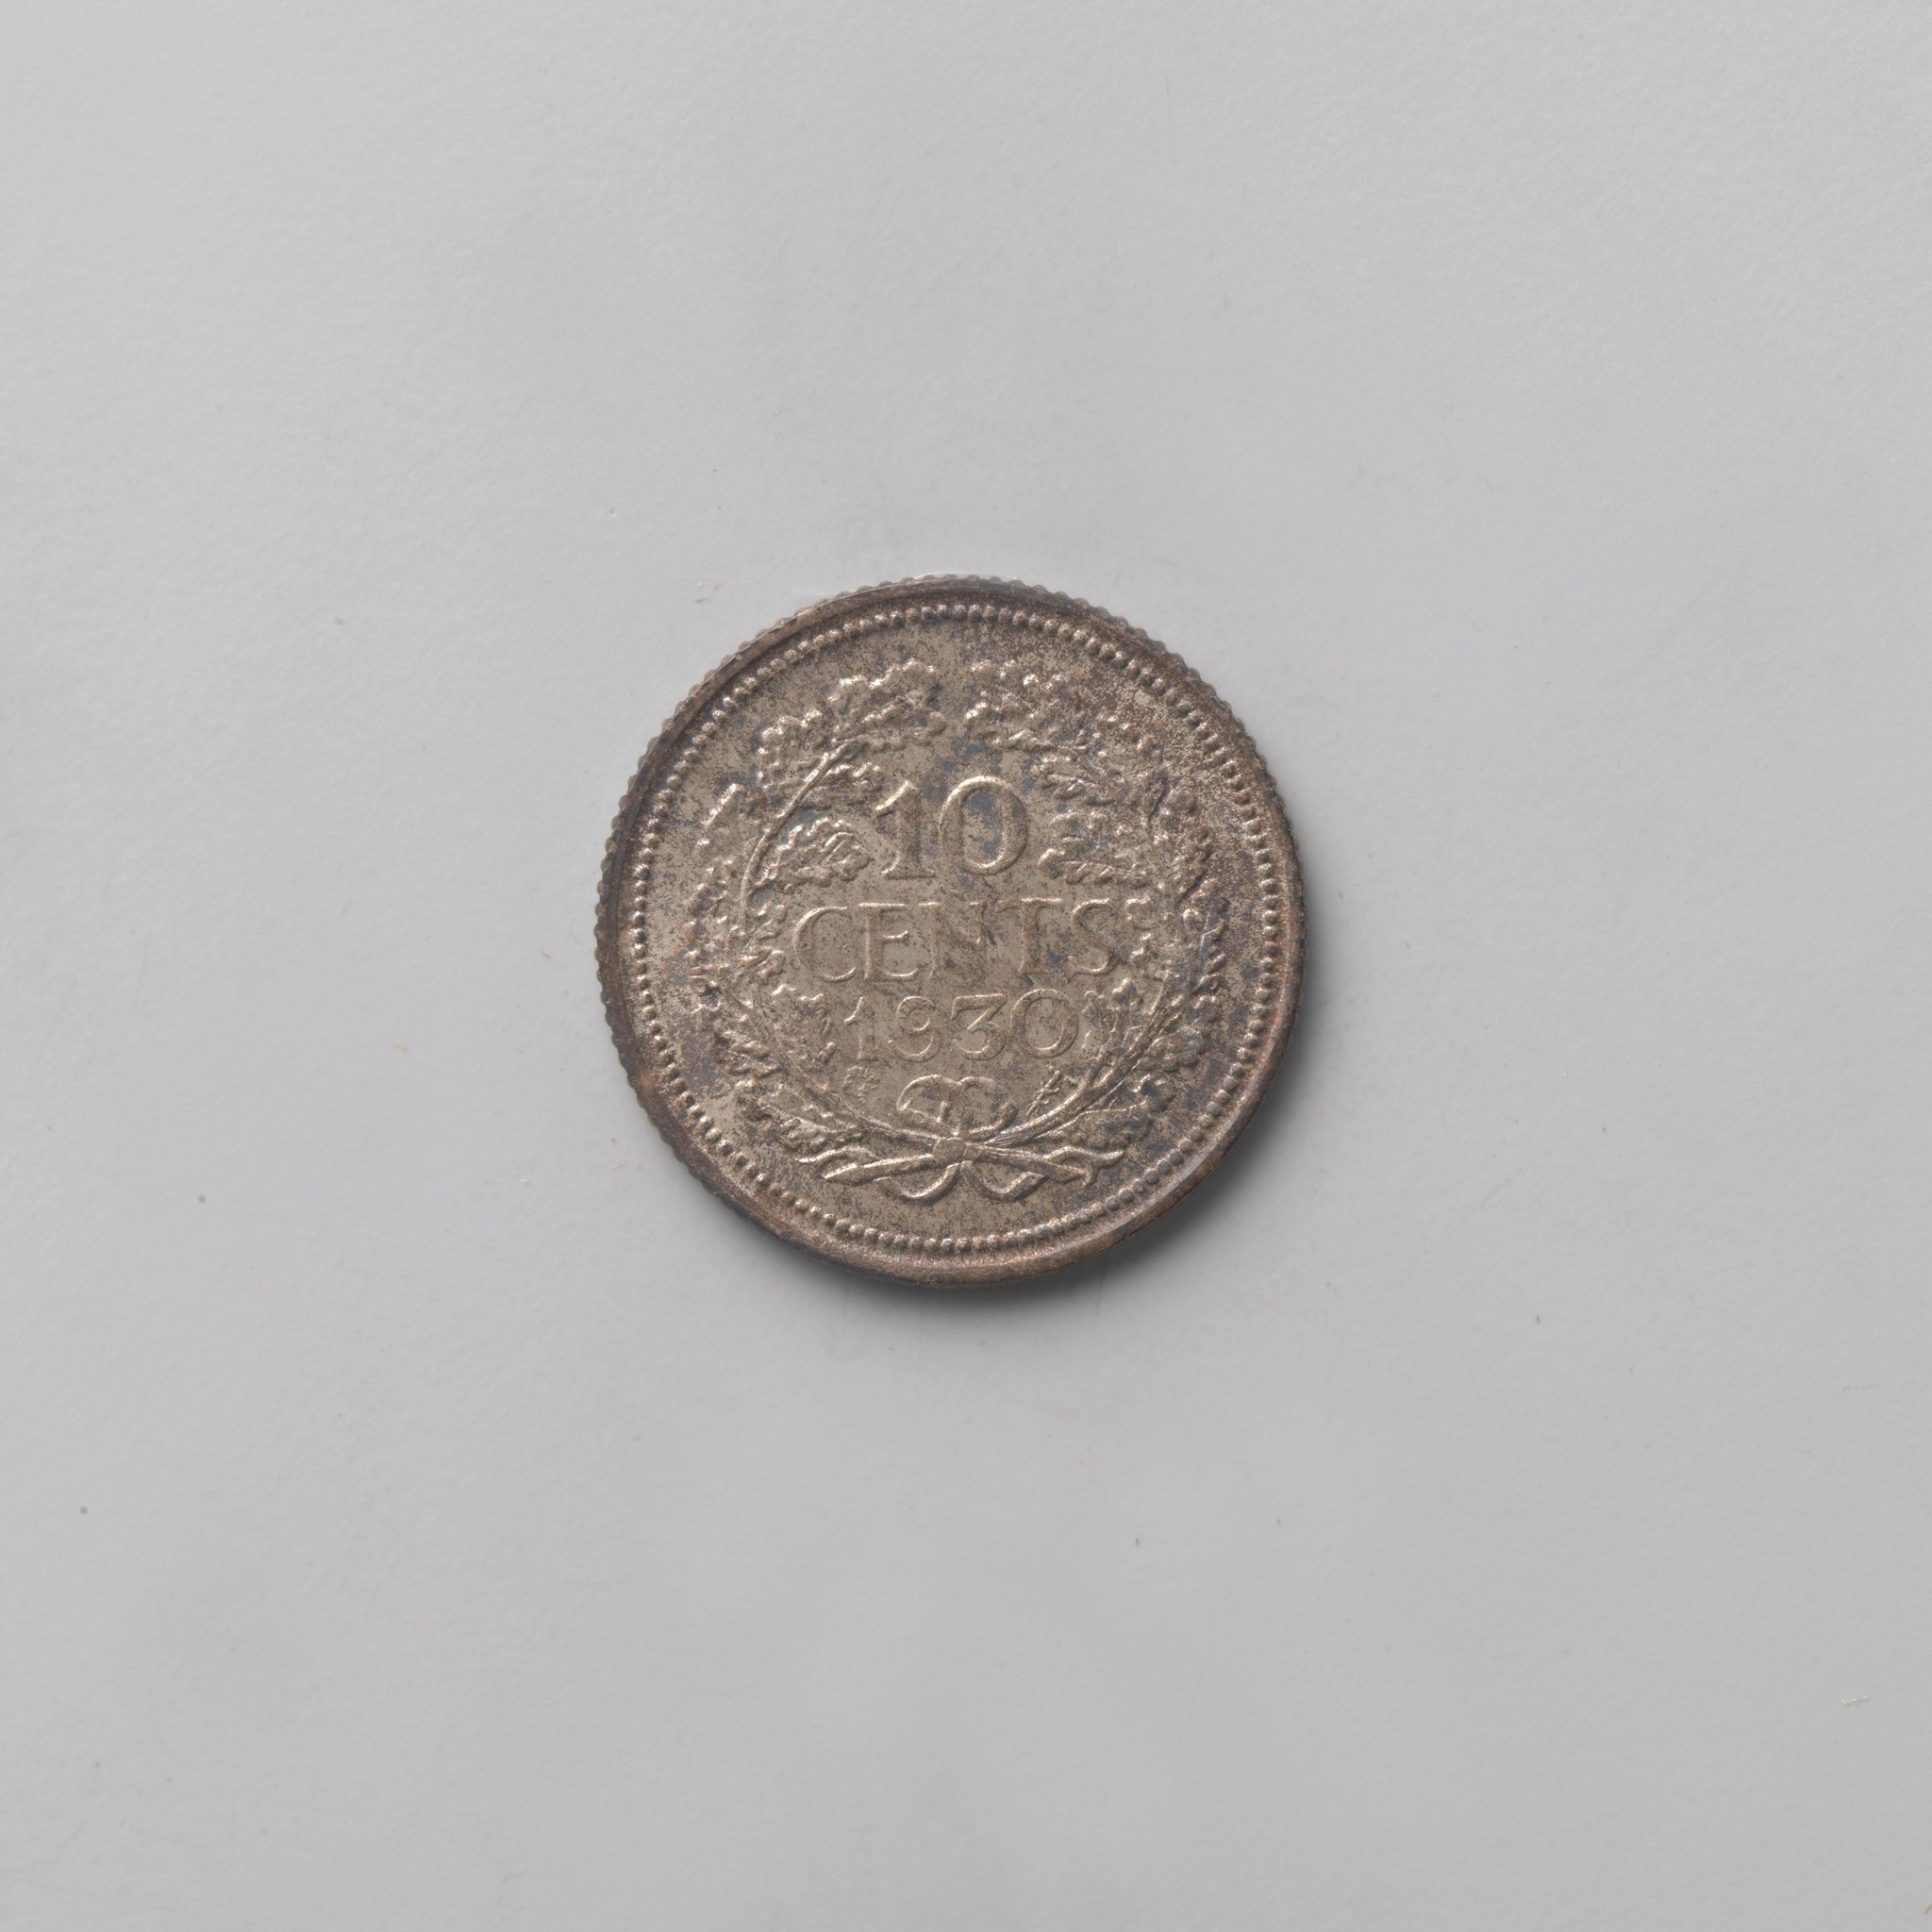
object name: coin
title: Nederland,10 cent,1930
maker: wilhelmina of the netherlands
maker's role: print maker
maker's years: 1880-1962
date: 1930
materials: silver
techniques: striking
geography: utrecht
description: Zilveren munt. Voorzijde: hoofd naar links. Keerzijde: binnen twee samengebonden eiketakken waarde-aanduiding 10 cents en jaartal. Kartelrand.